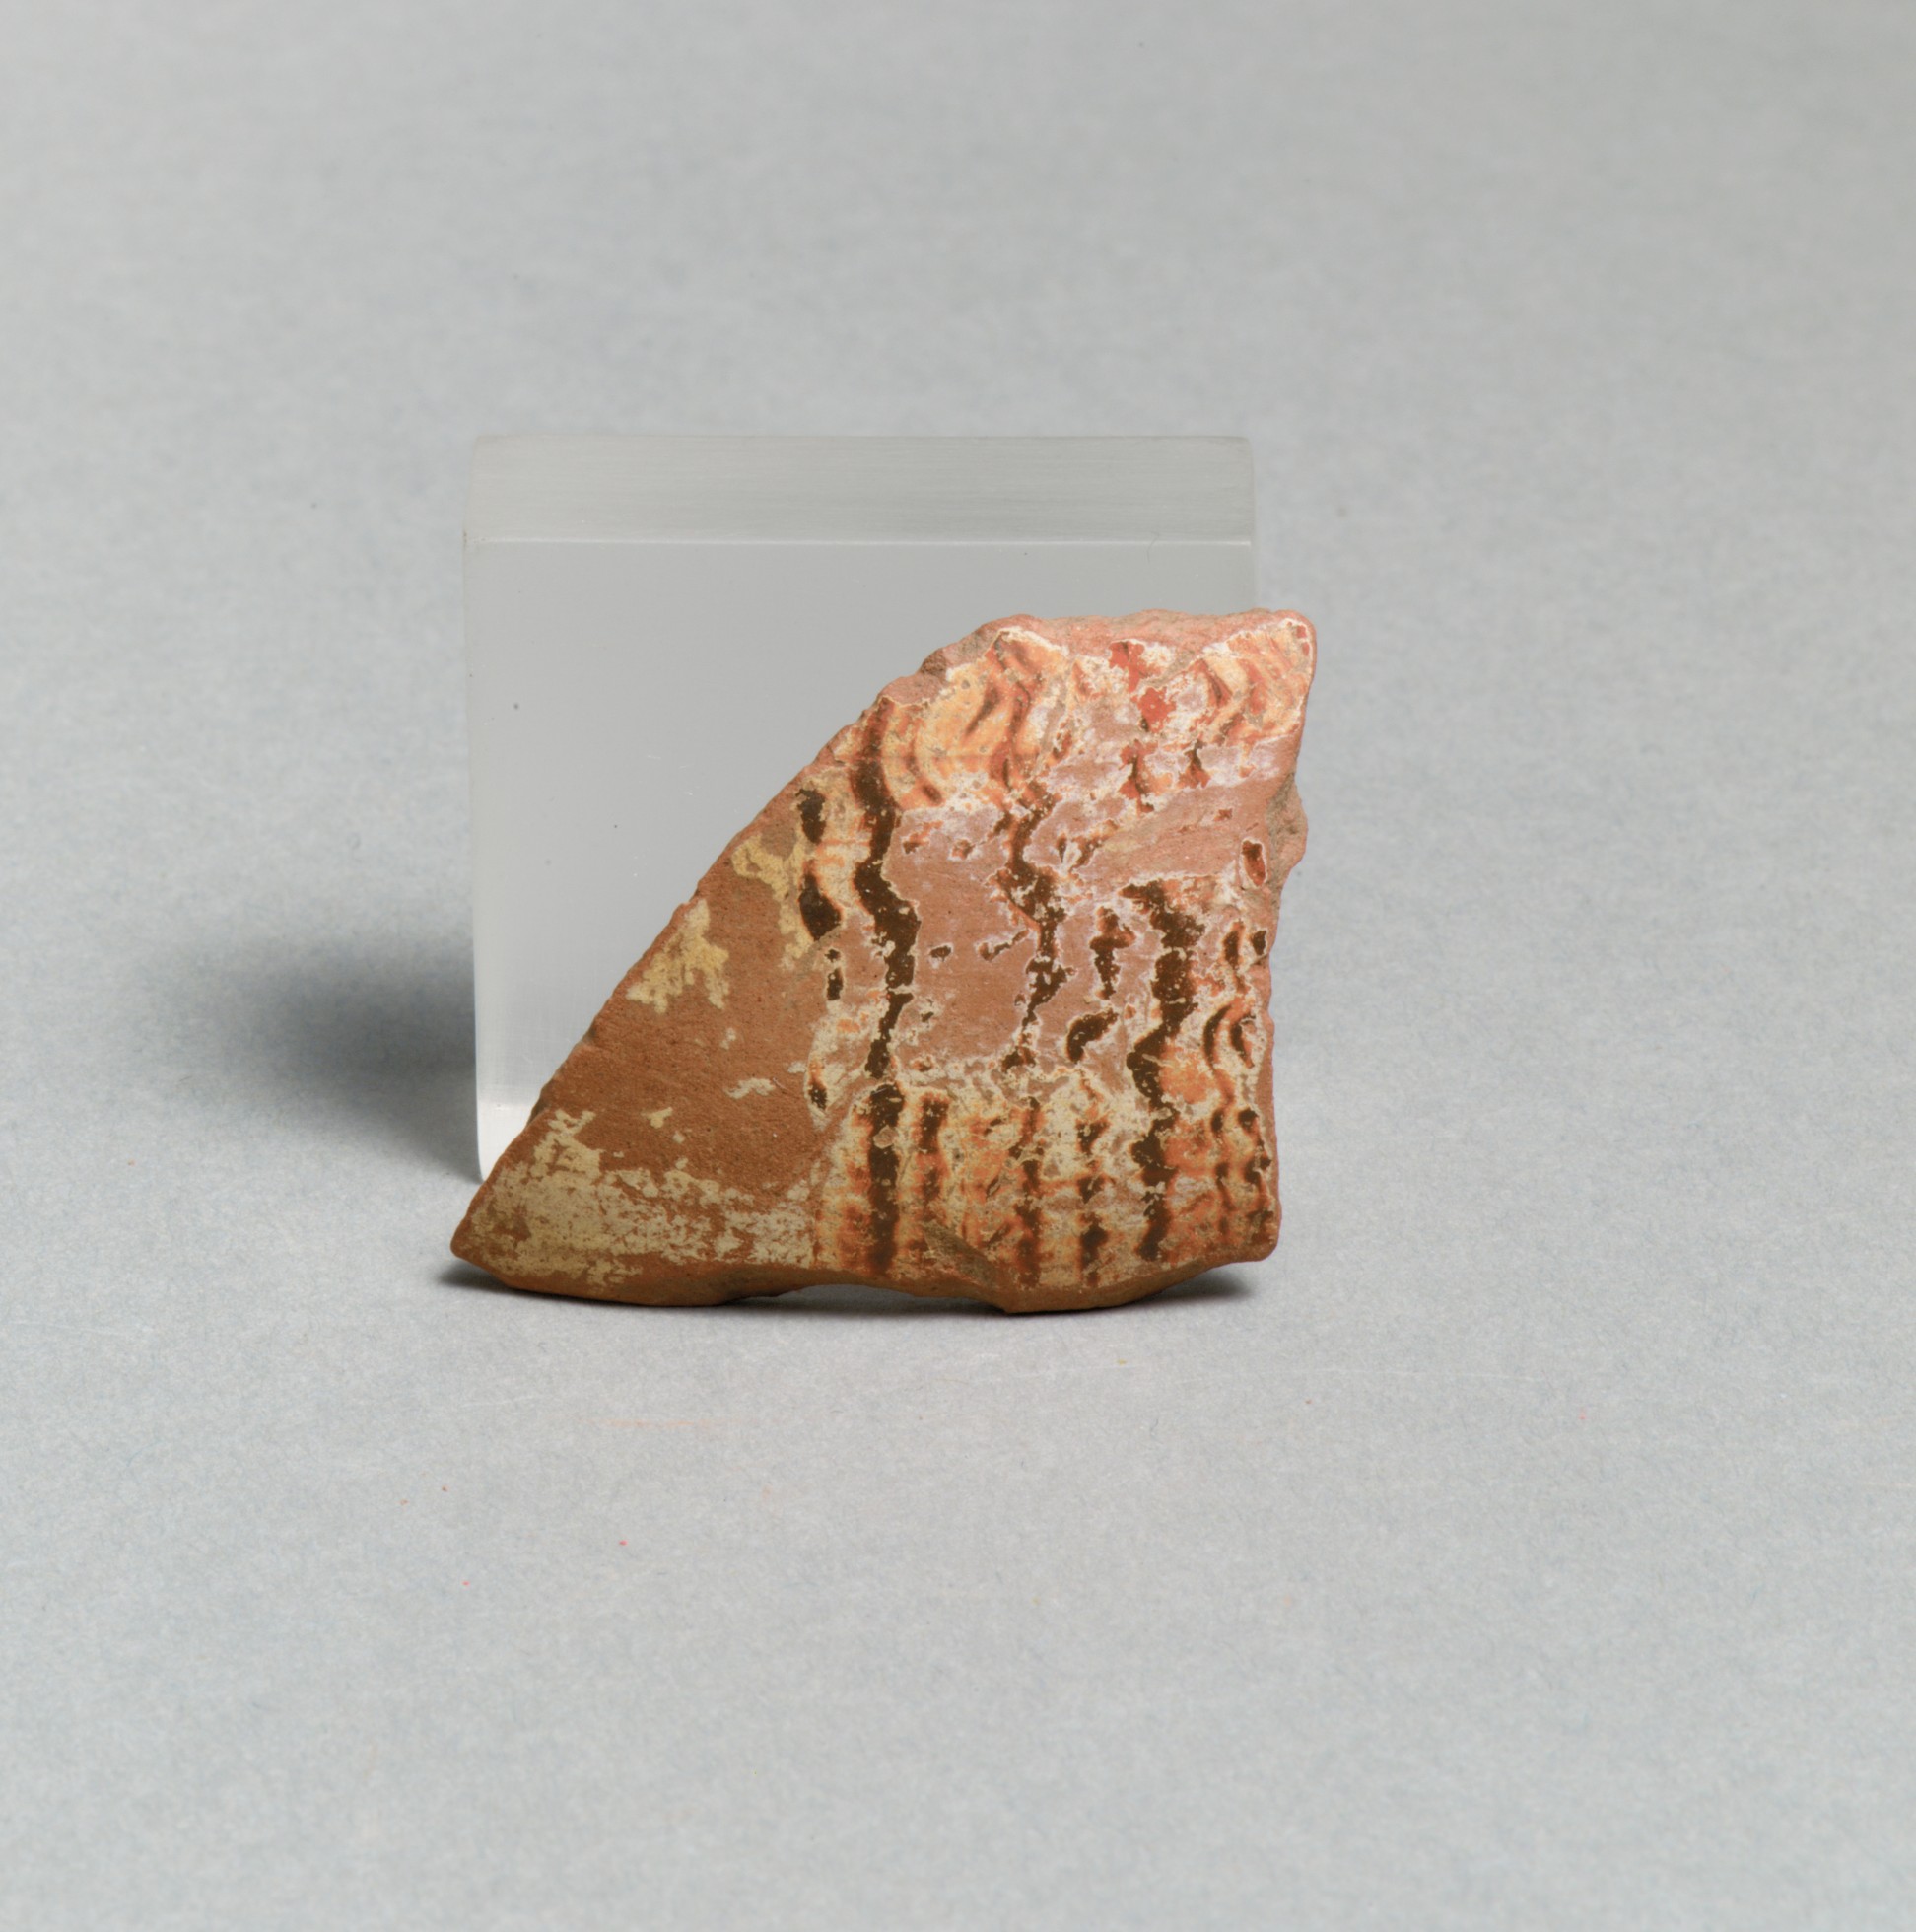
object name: skyphos fragment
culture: greek or lydian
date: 900-30 BCE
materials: terracotta